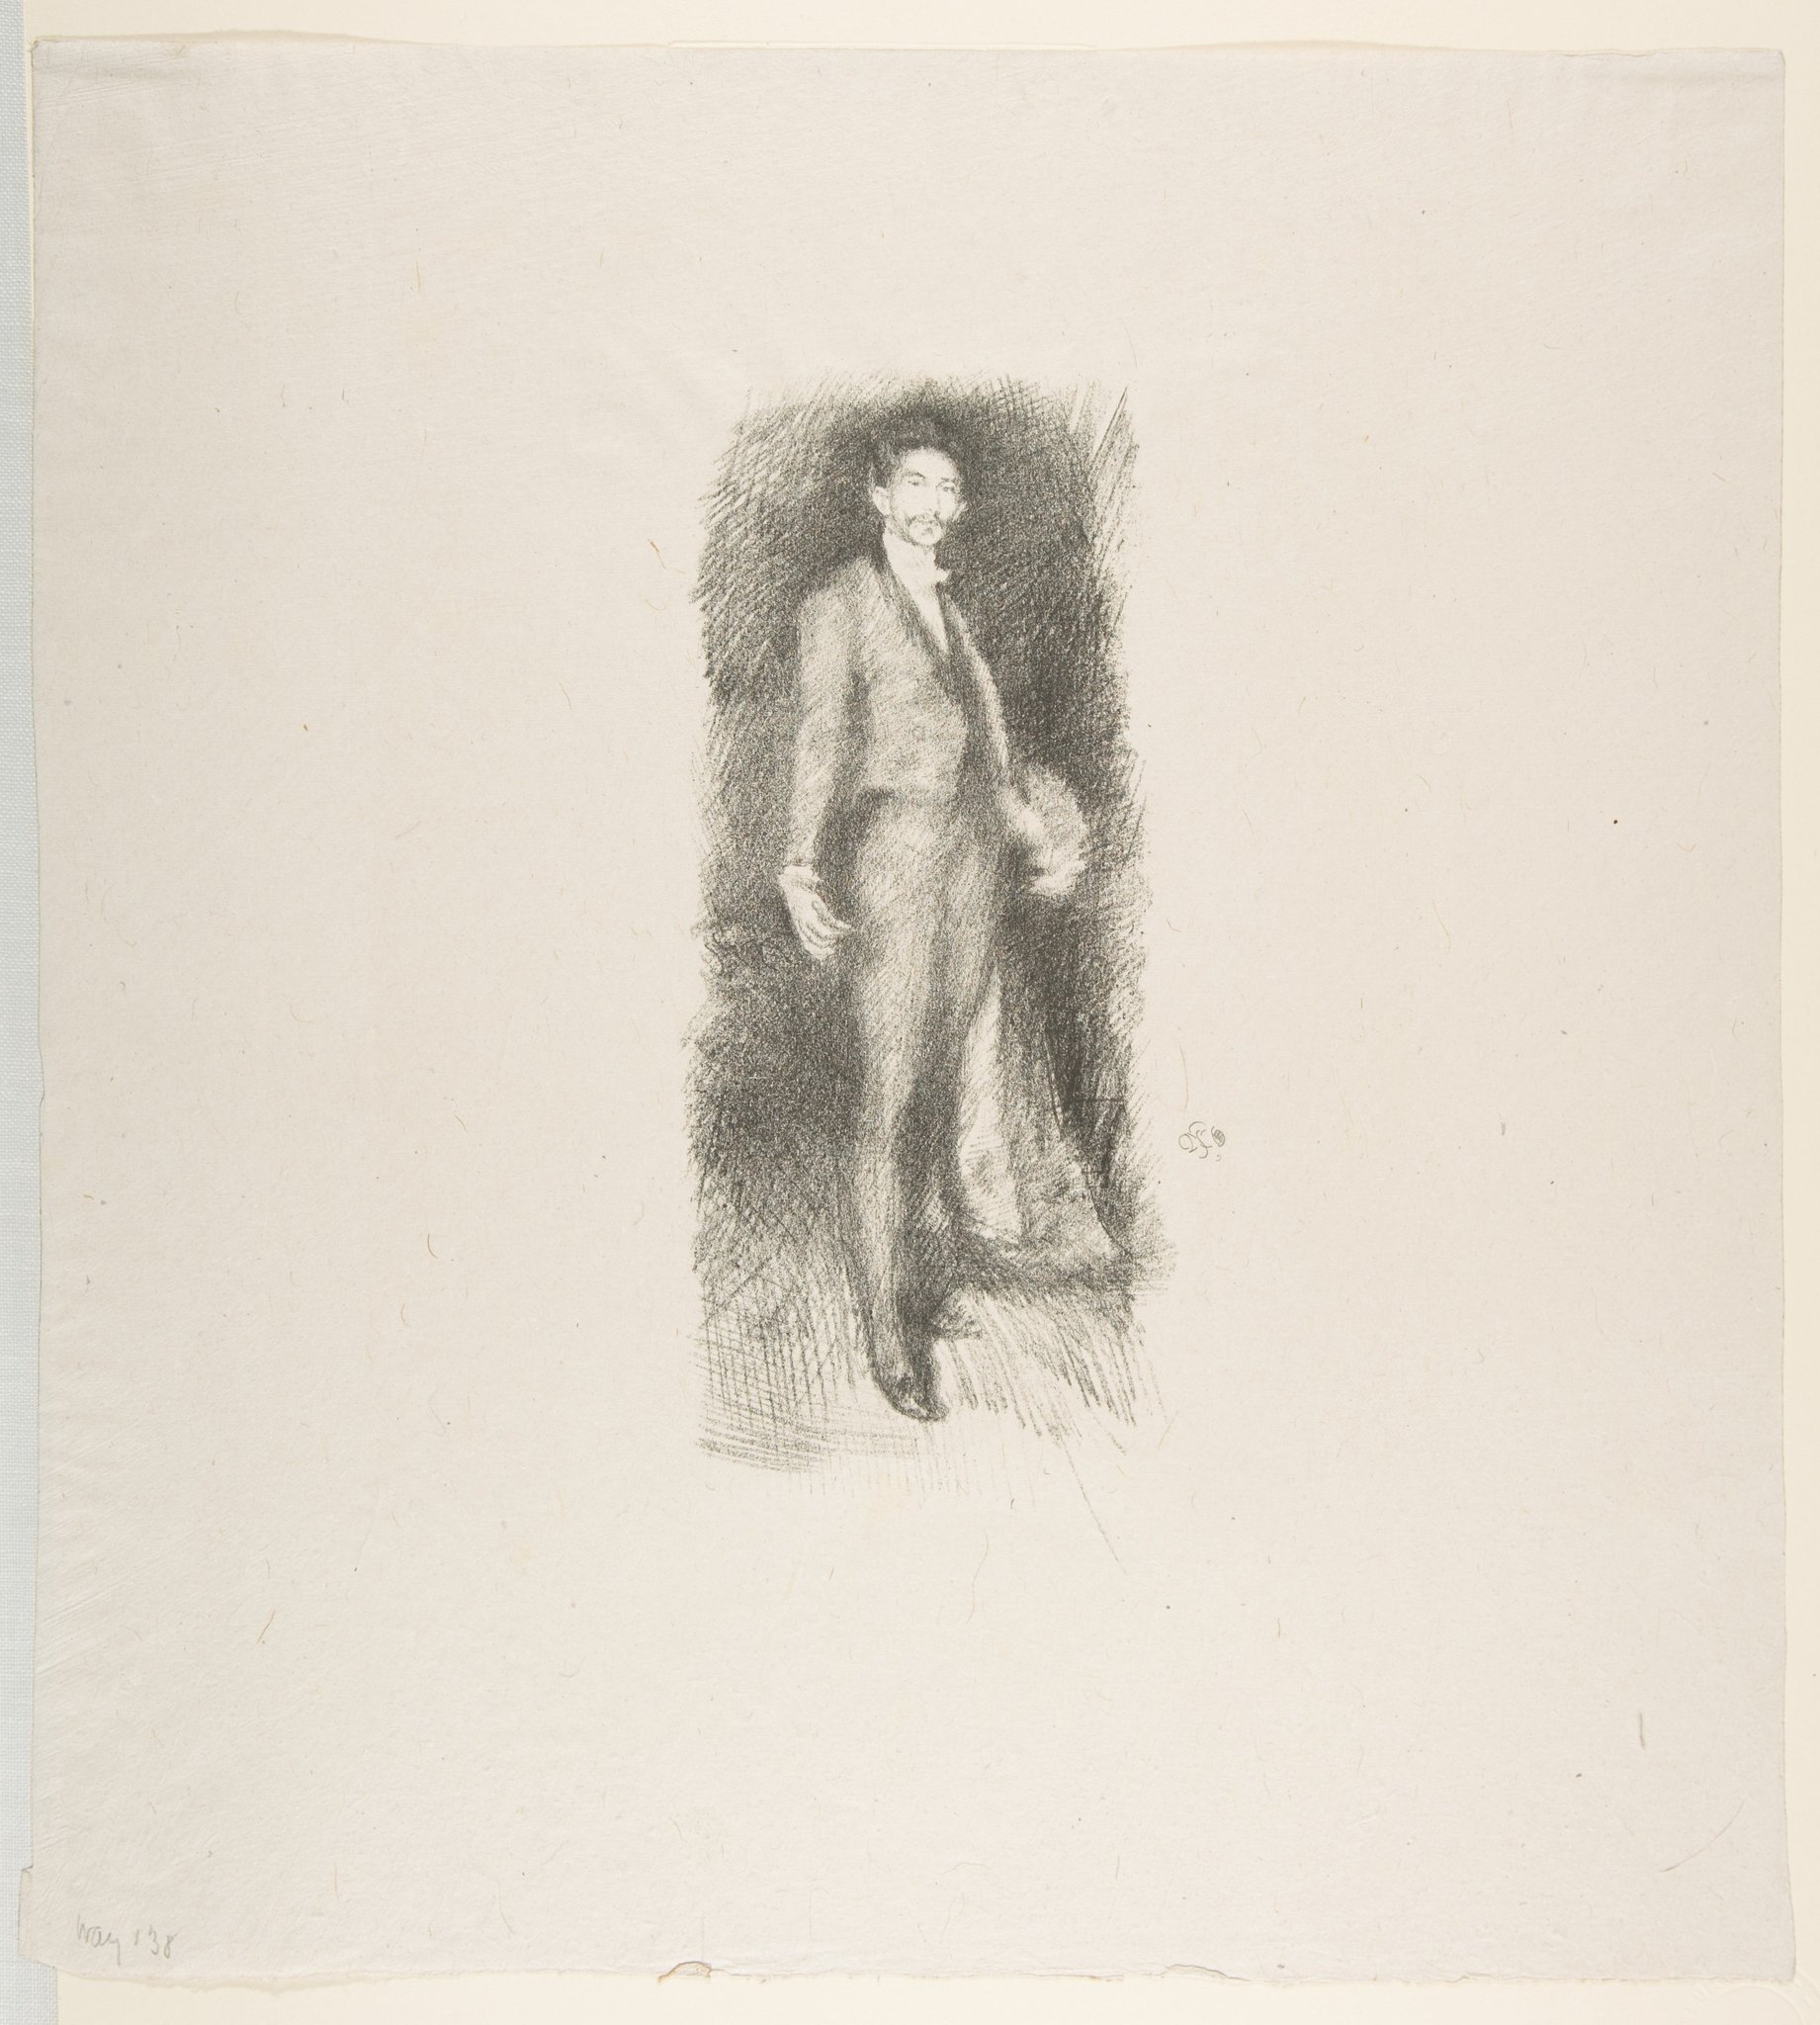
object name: print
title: Count Robert de Montesquiou, No. 2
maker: james mcneill whistler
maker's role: artist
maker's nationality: american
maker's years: 1834-1903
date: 1894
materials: paper, ink, ivory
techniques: drawing, printing, scraping, transfer, lithography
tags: men